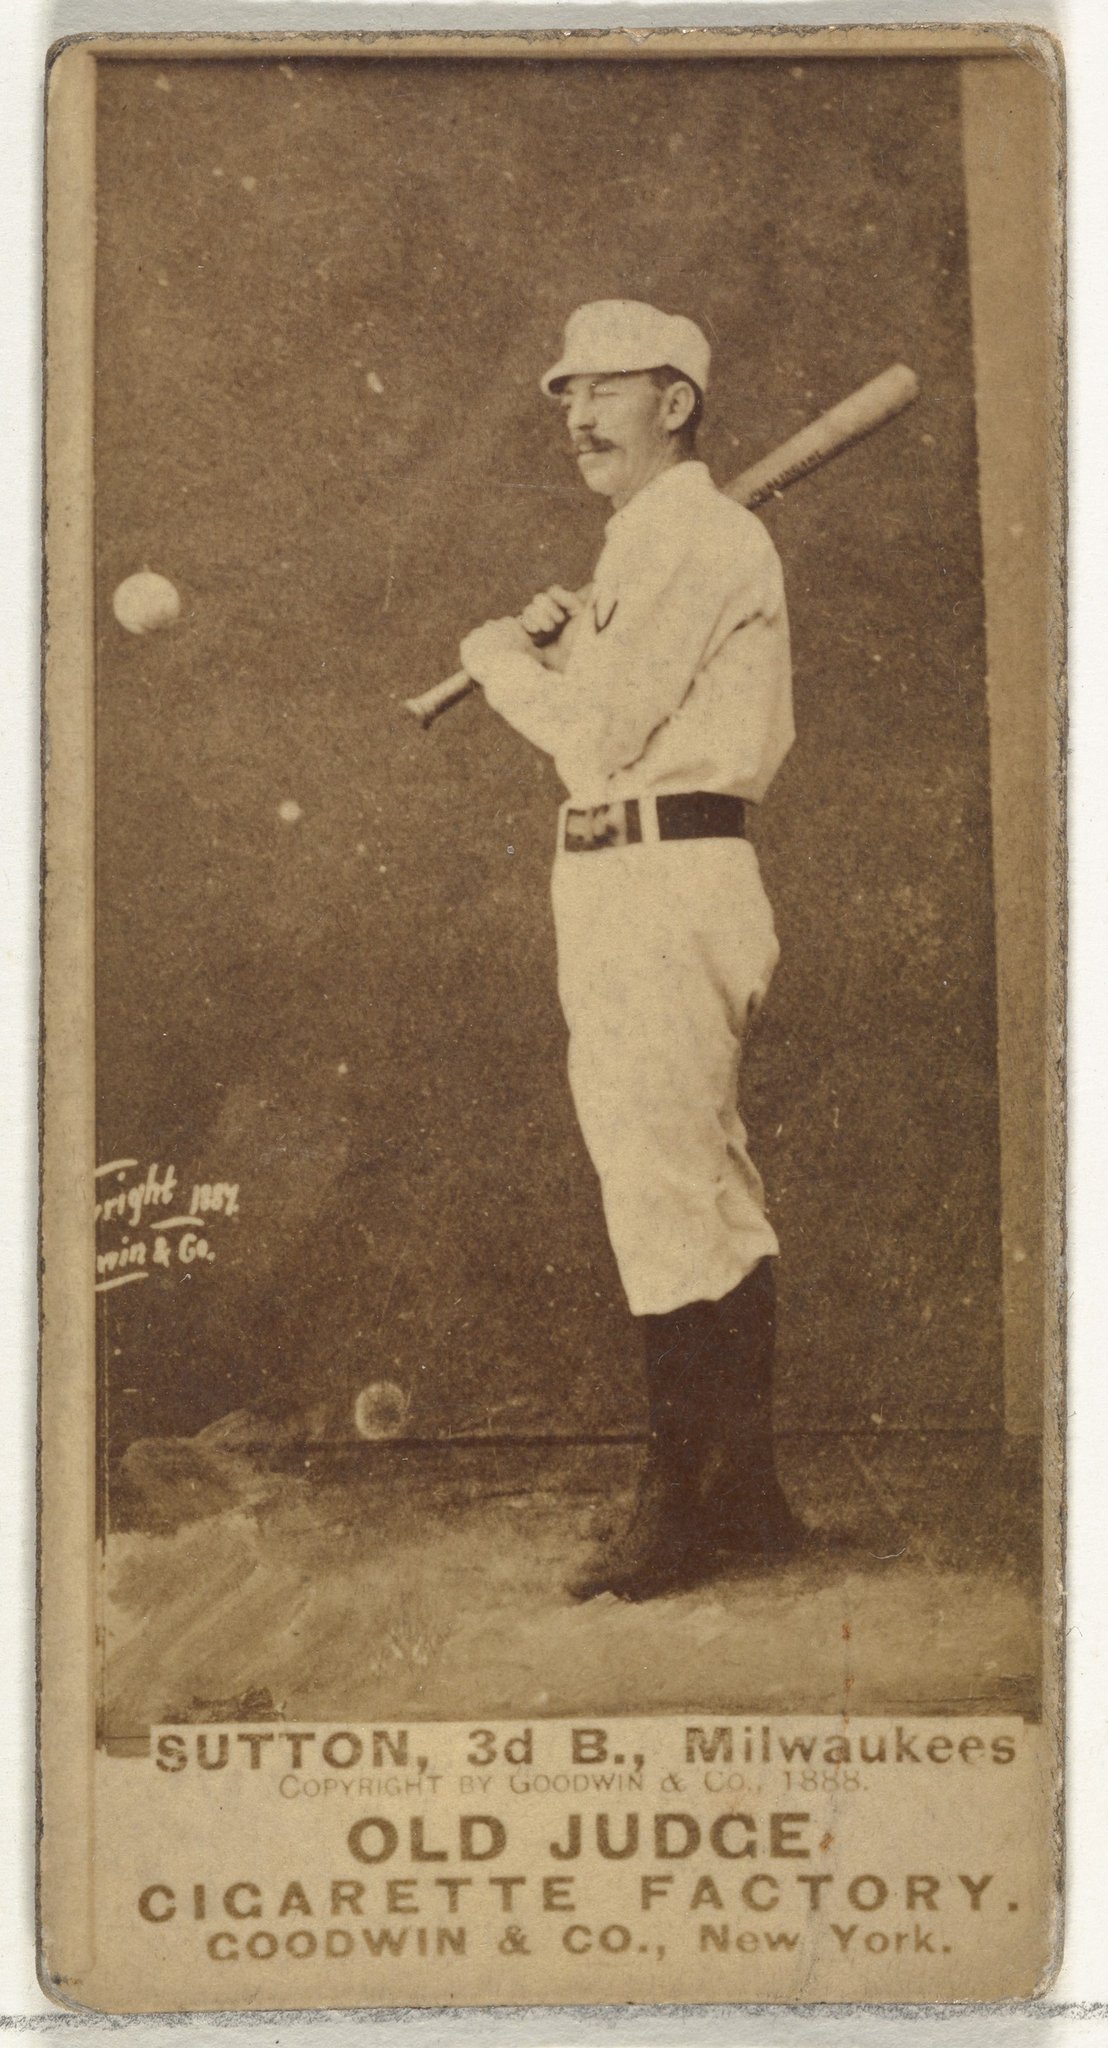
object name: baseball card, photograph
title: Ezra Ballou Sutton, 3rd Base, Milwaukee, from the Old Judge series (N172) for Old Judge Cigarettes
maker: goodwin & company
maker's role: publisher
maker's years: 1850-1950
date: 1888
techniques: albumen silver print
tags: men,portraits,baseball,athletes